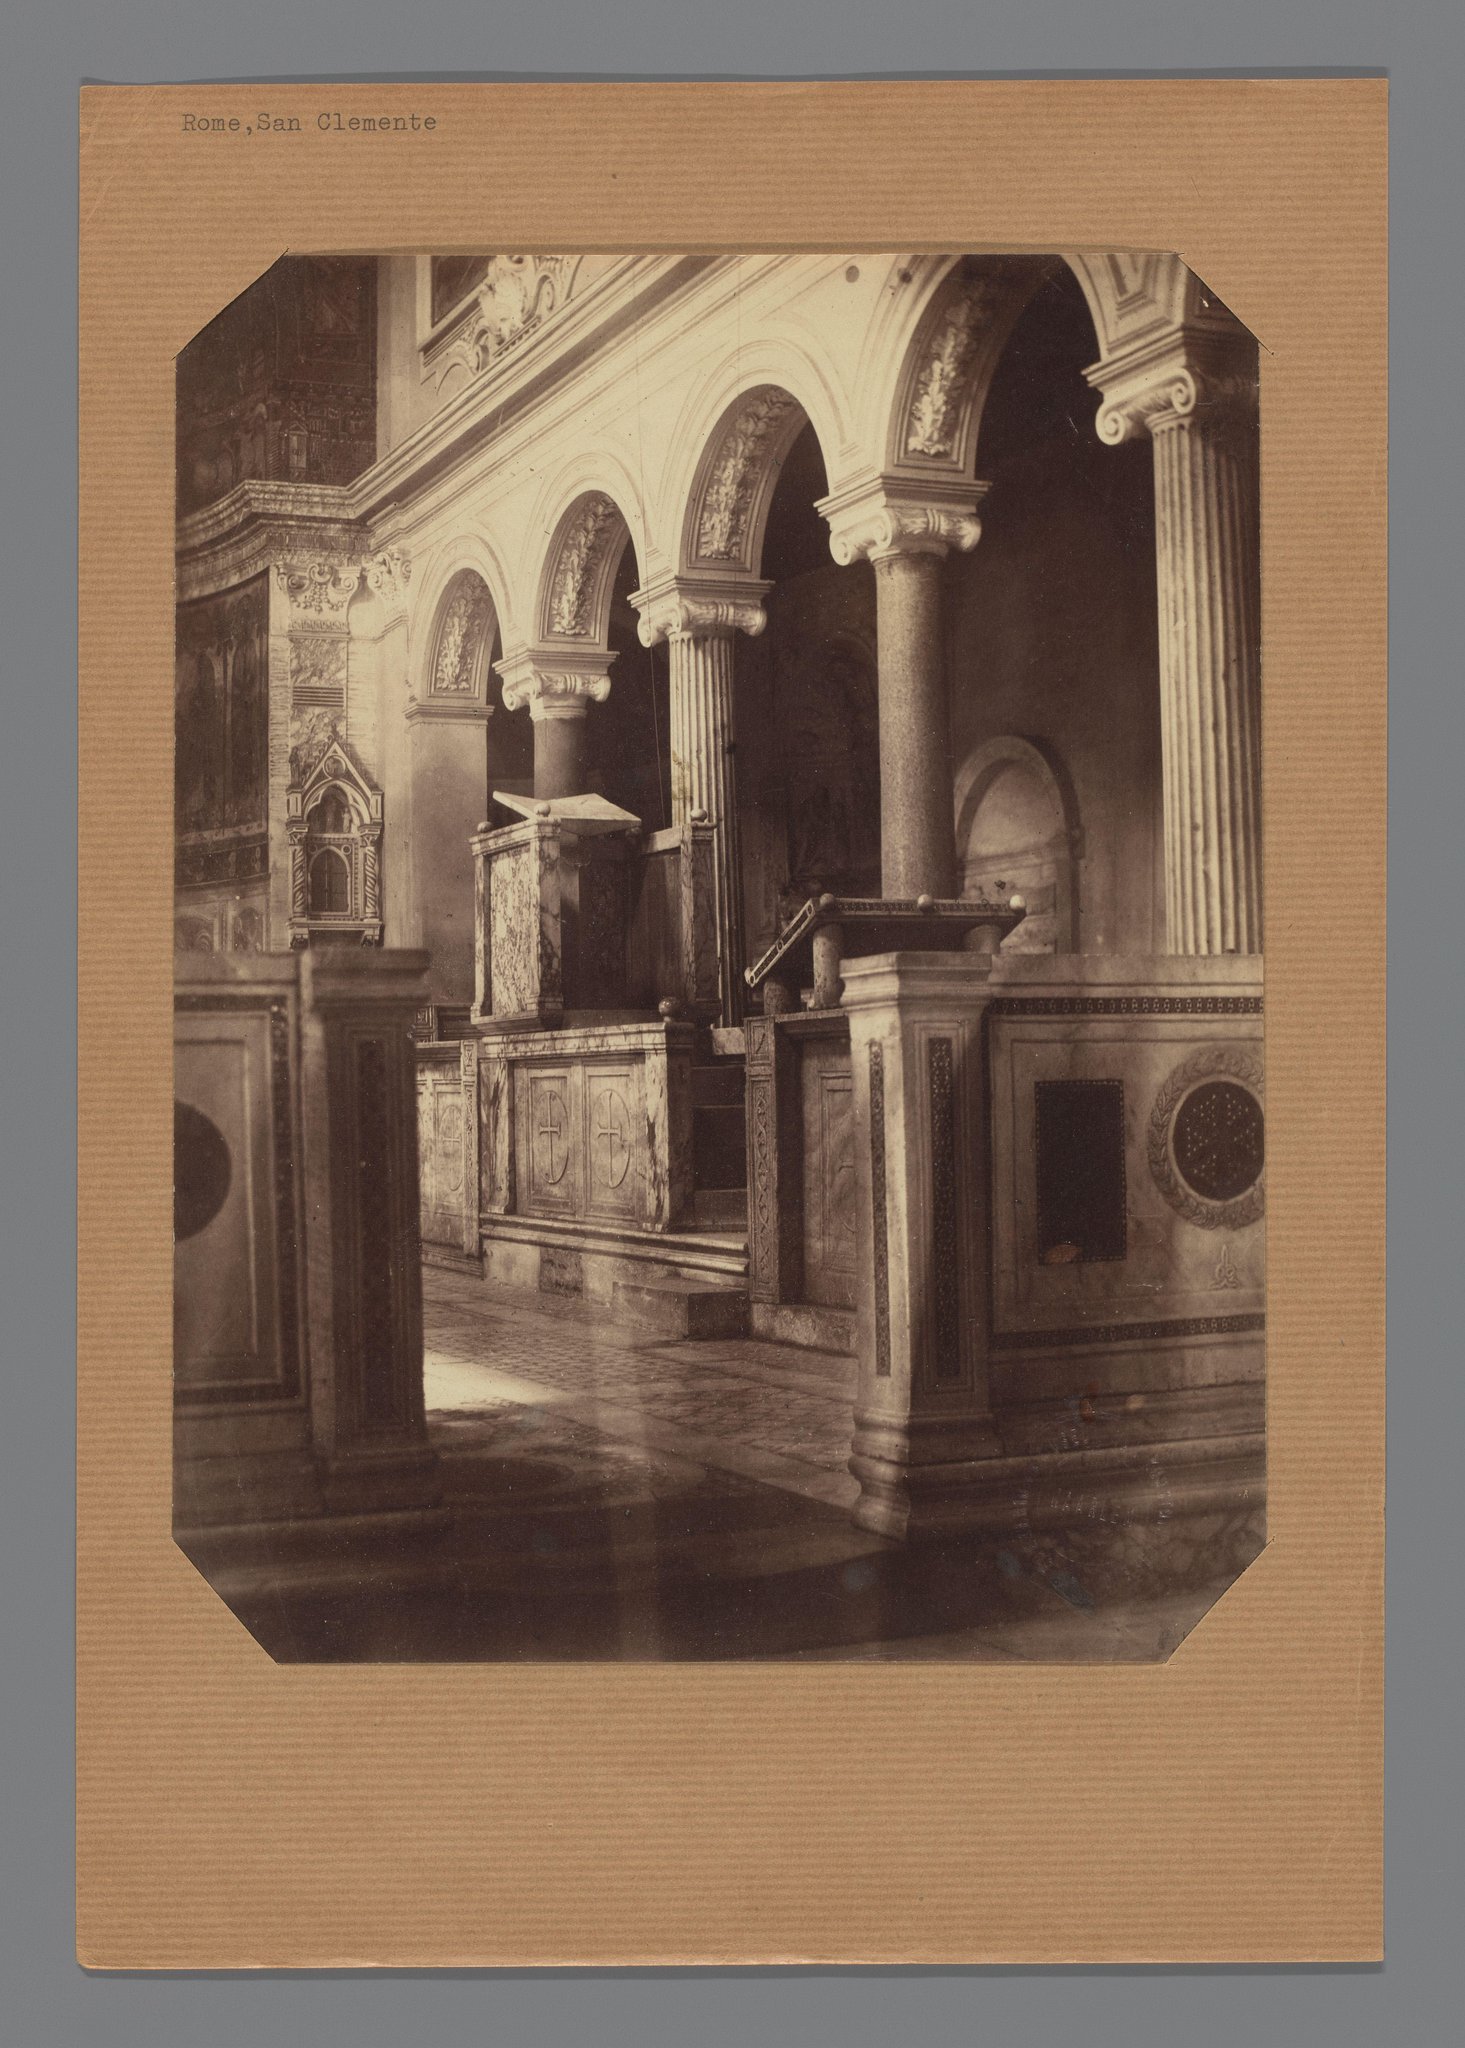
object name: photograph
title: San Clemente, Rome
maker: Anonymous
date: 1850-1899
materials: paper, photographic support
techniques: albumen print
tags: san clemente